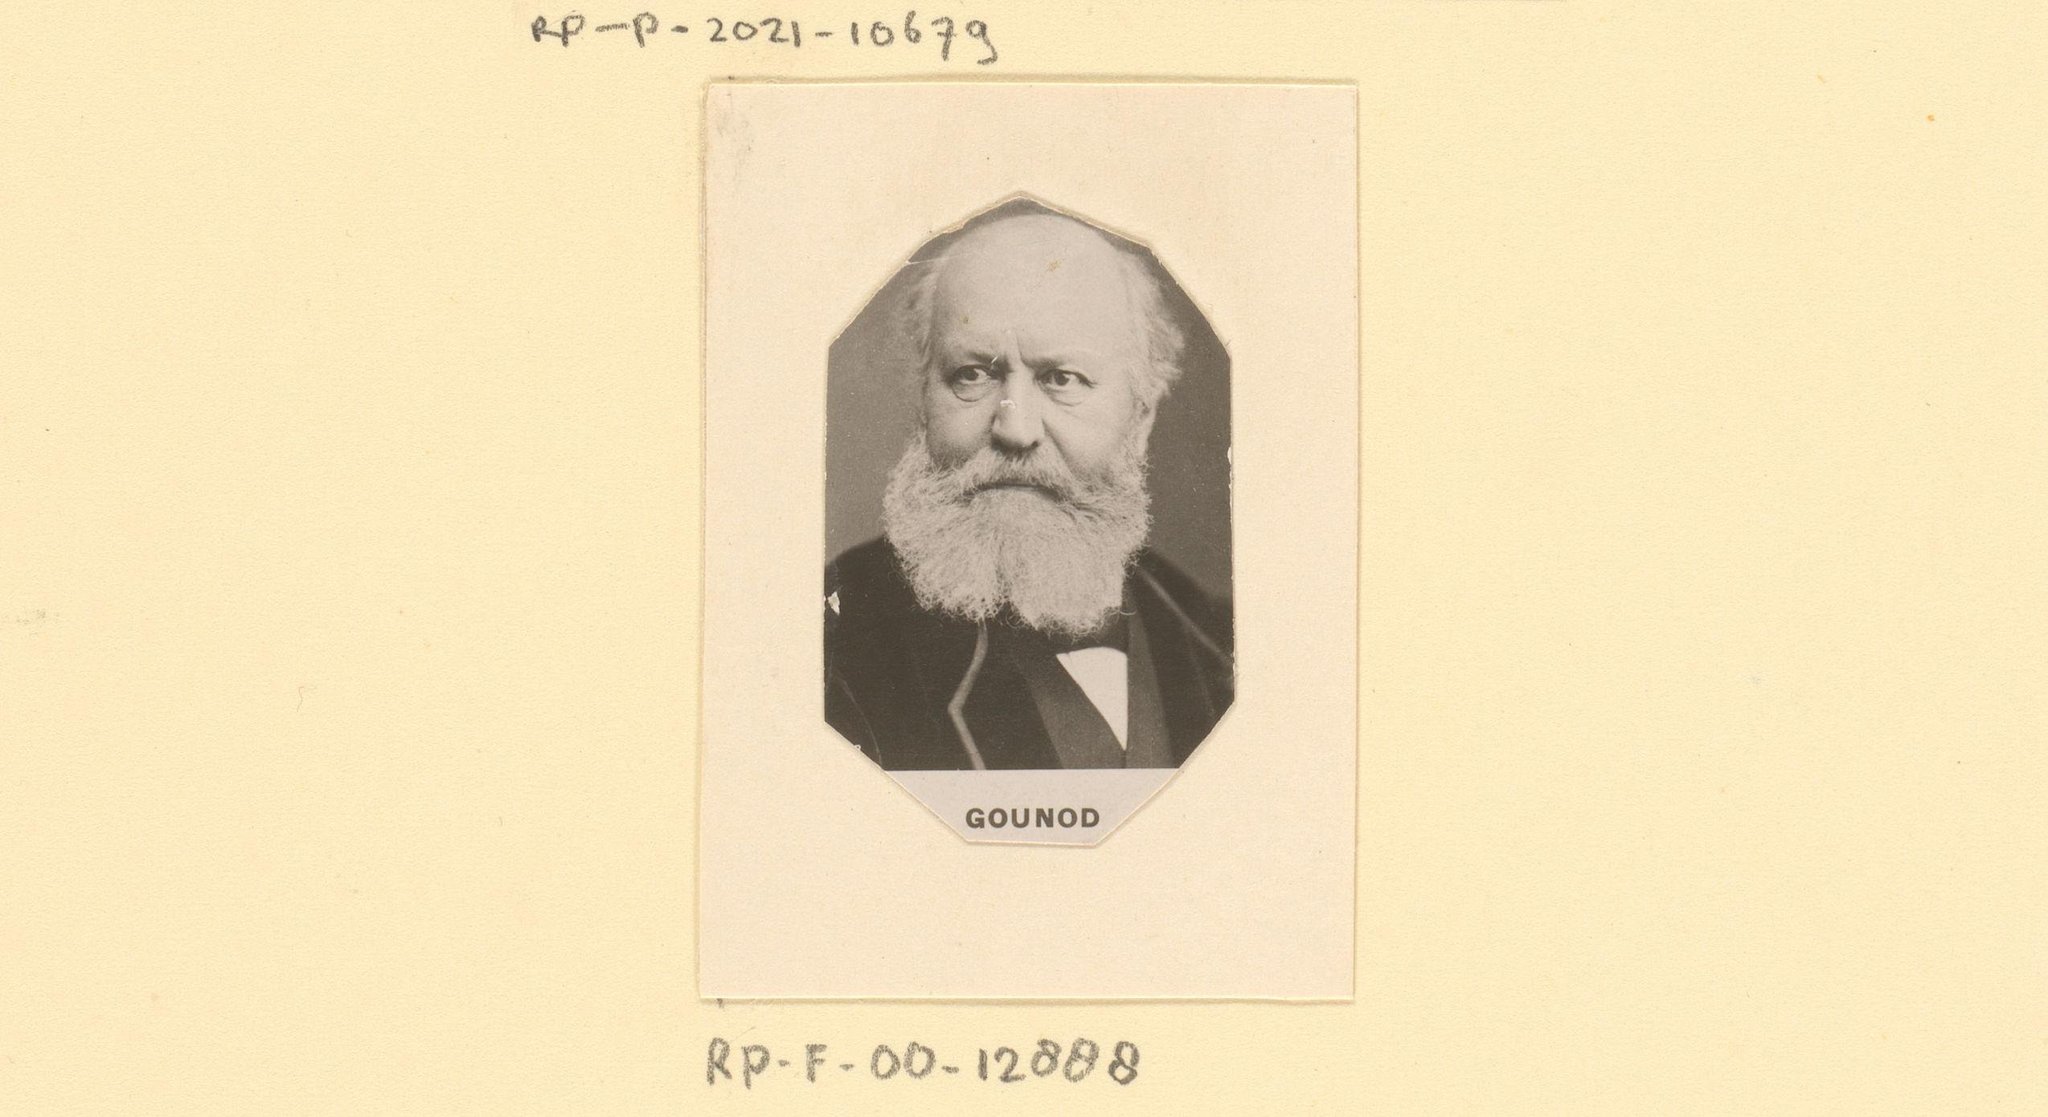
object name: photograph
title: Portret van Charles Gounod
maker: Anonymous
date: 1900-1930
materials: paper, cardboard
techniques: gelatin silver print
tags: charles gounod, historical persons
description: Dergelijke foto's stonden bekend als 'zwartjes'. Men verkreeg ze bij aanschaf van bepaalde merken thee, cacao, sigaretten, beschuit, etc. om te verzamelen. Er waren speciaal voor de 'zwartjes' vervaardigde verzamelalbums in omloop.